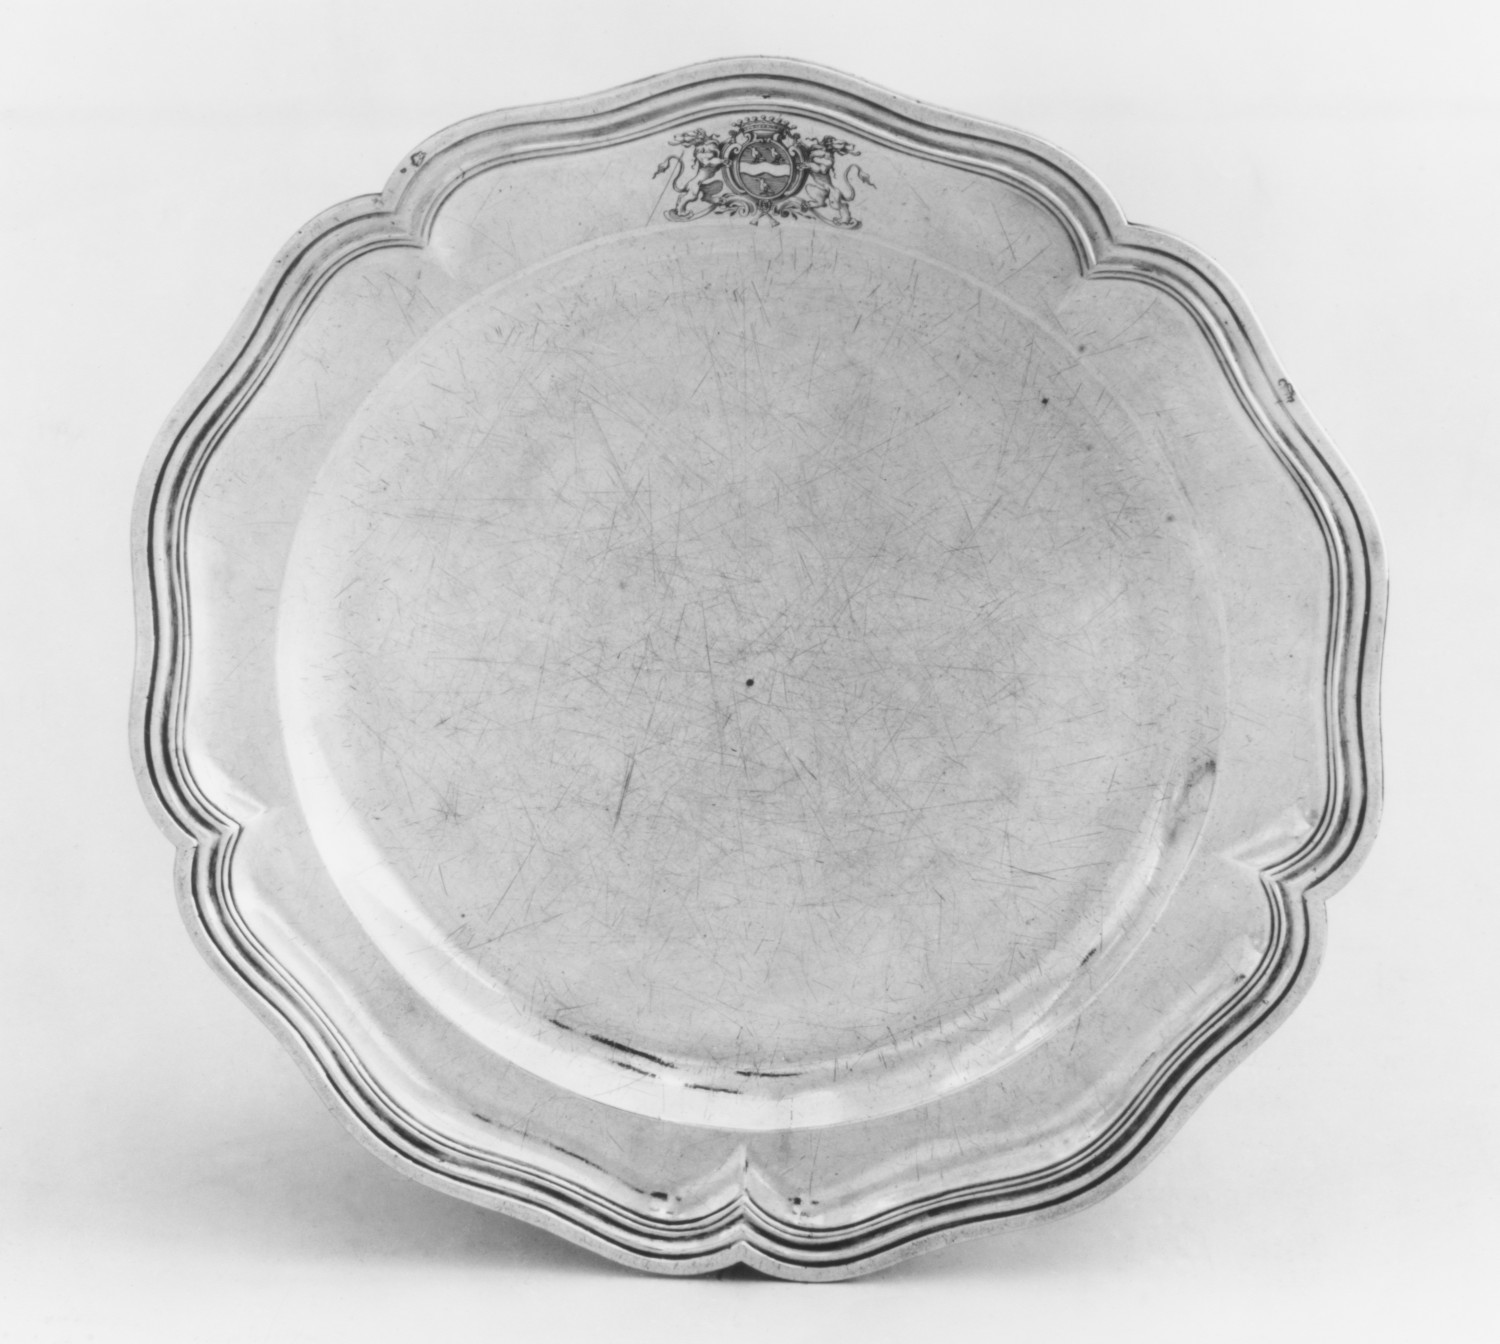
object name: plate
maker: paul soulaine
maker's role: maker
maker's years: 1659-1759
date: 1755-1756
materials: silver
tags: coat of arms